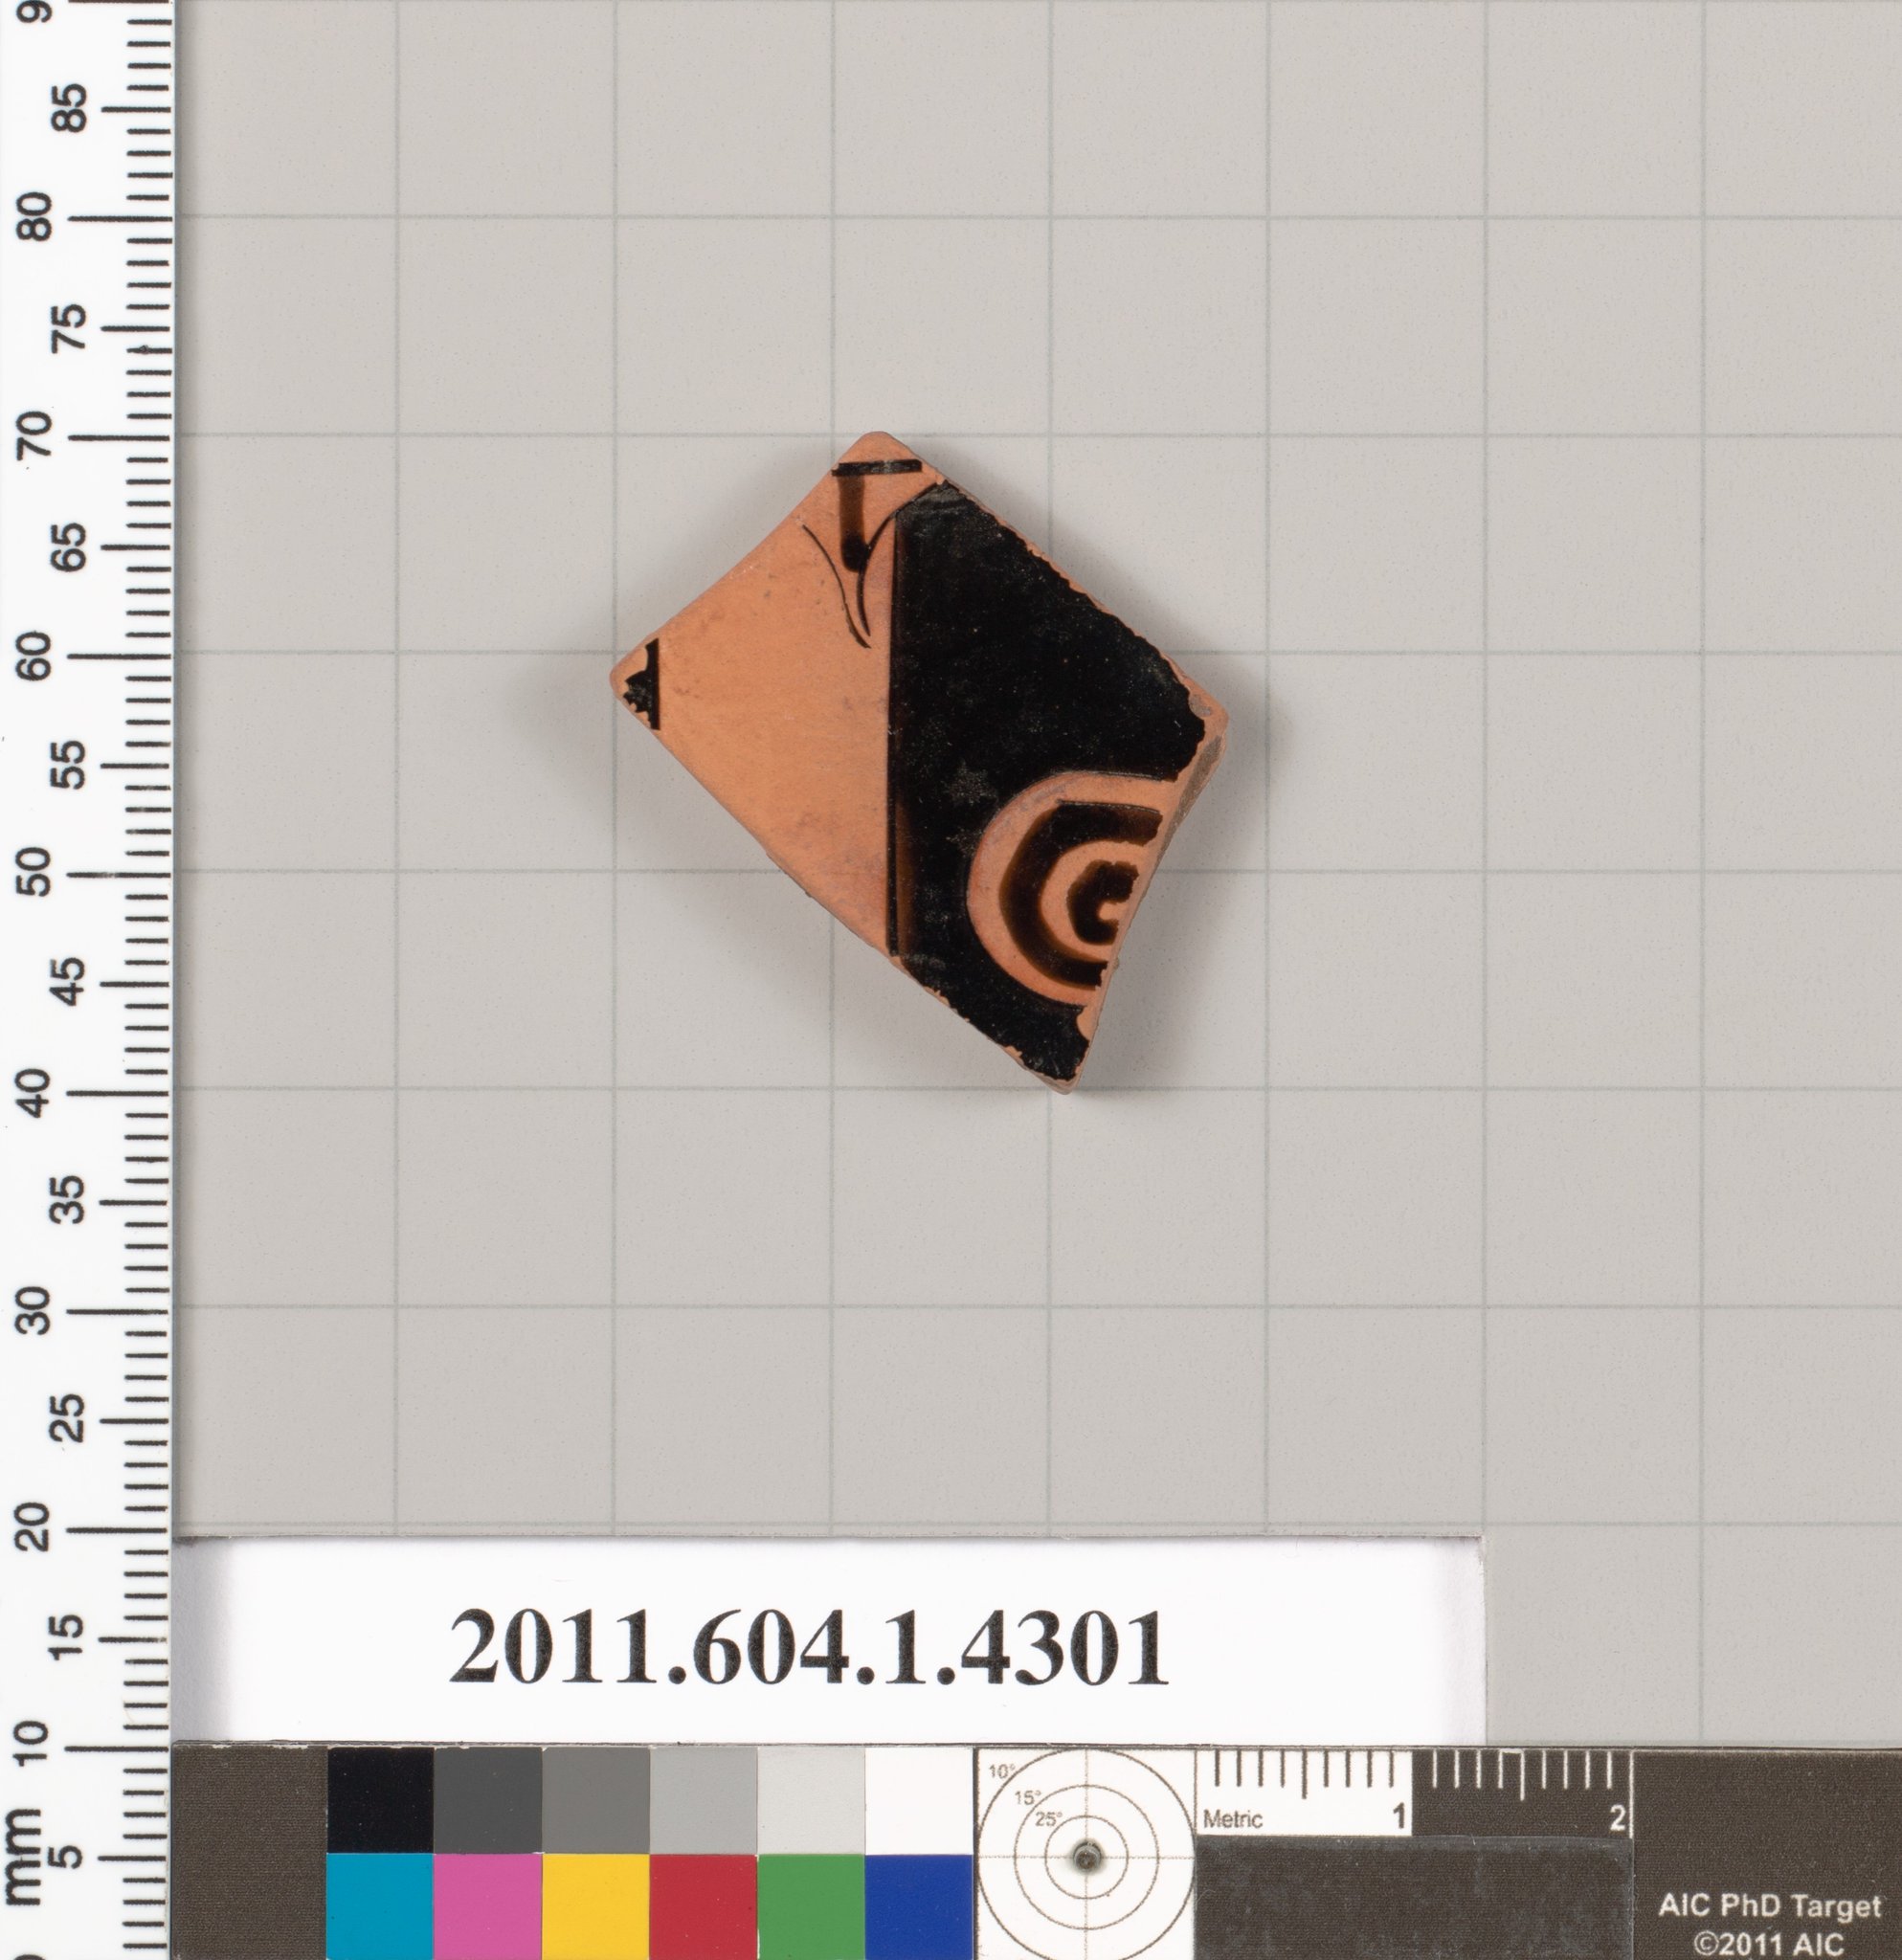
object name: kylix fragment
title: Terracotta fragment of a kylix (drinking cup)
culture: greek, attic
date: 475-451 BCE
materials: terracotta